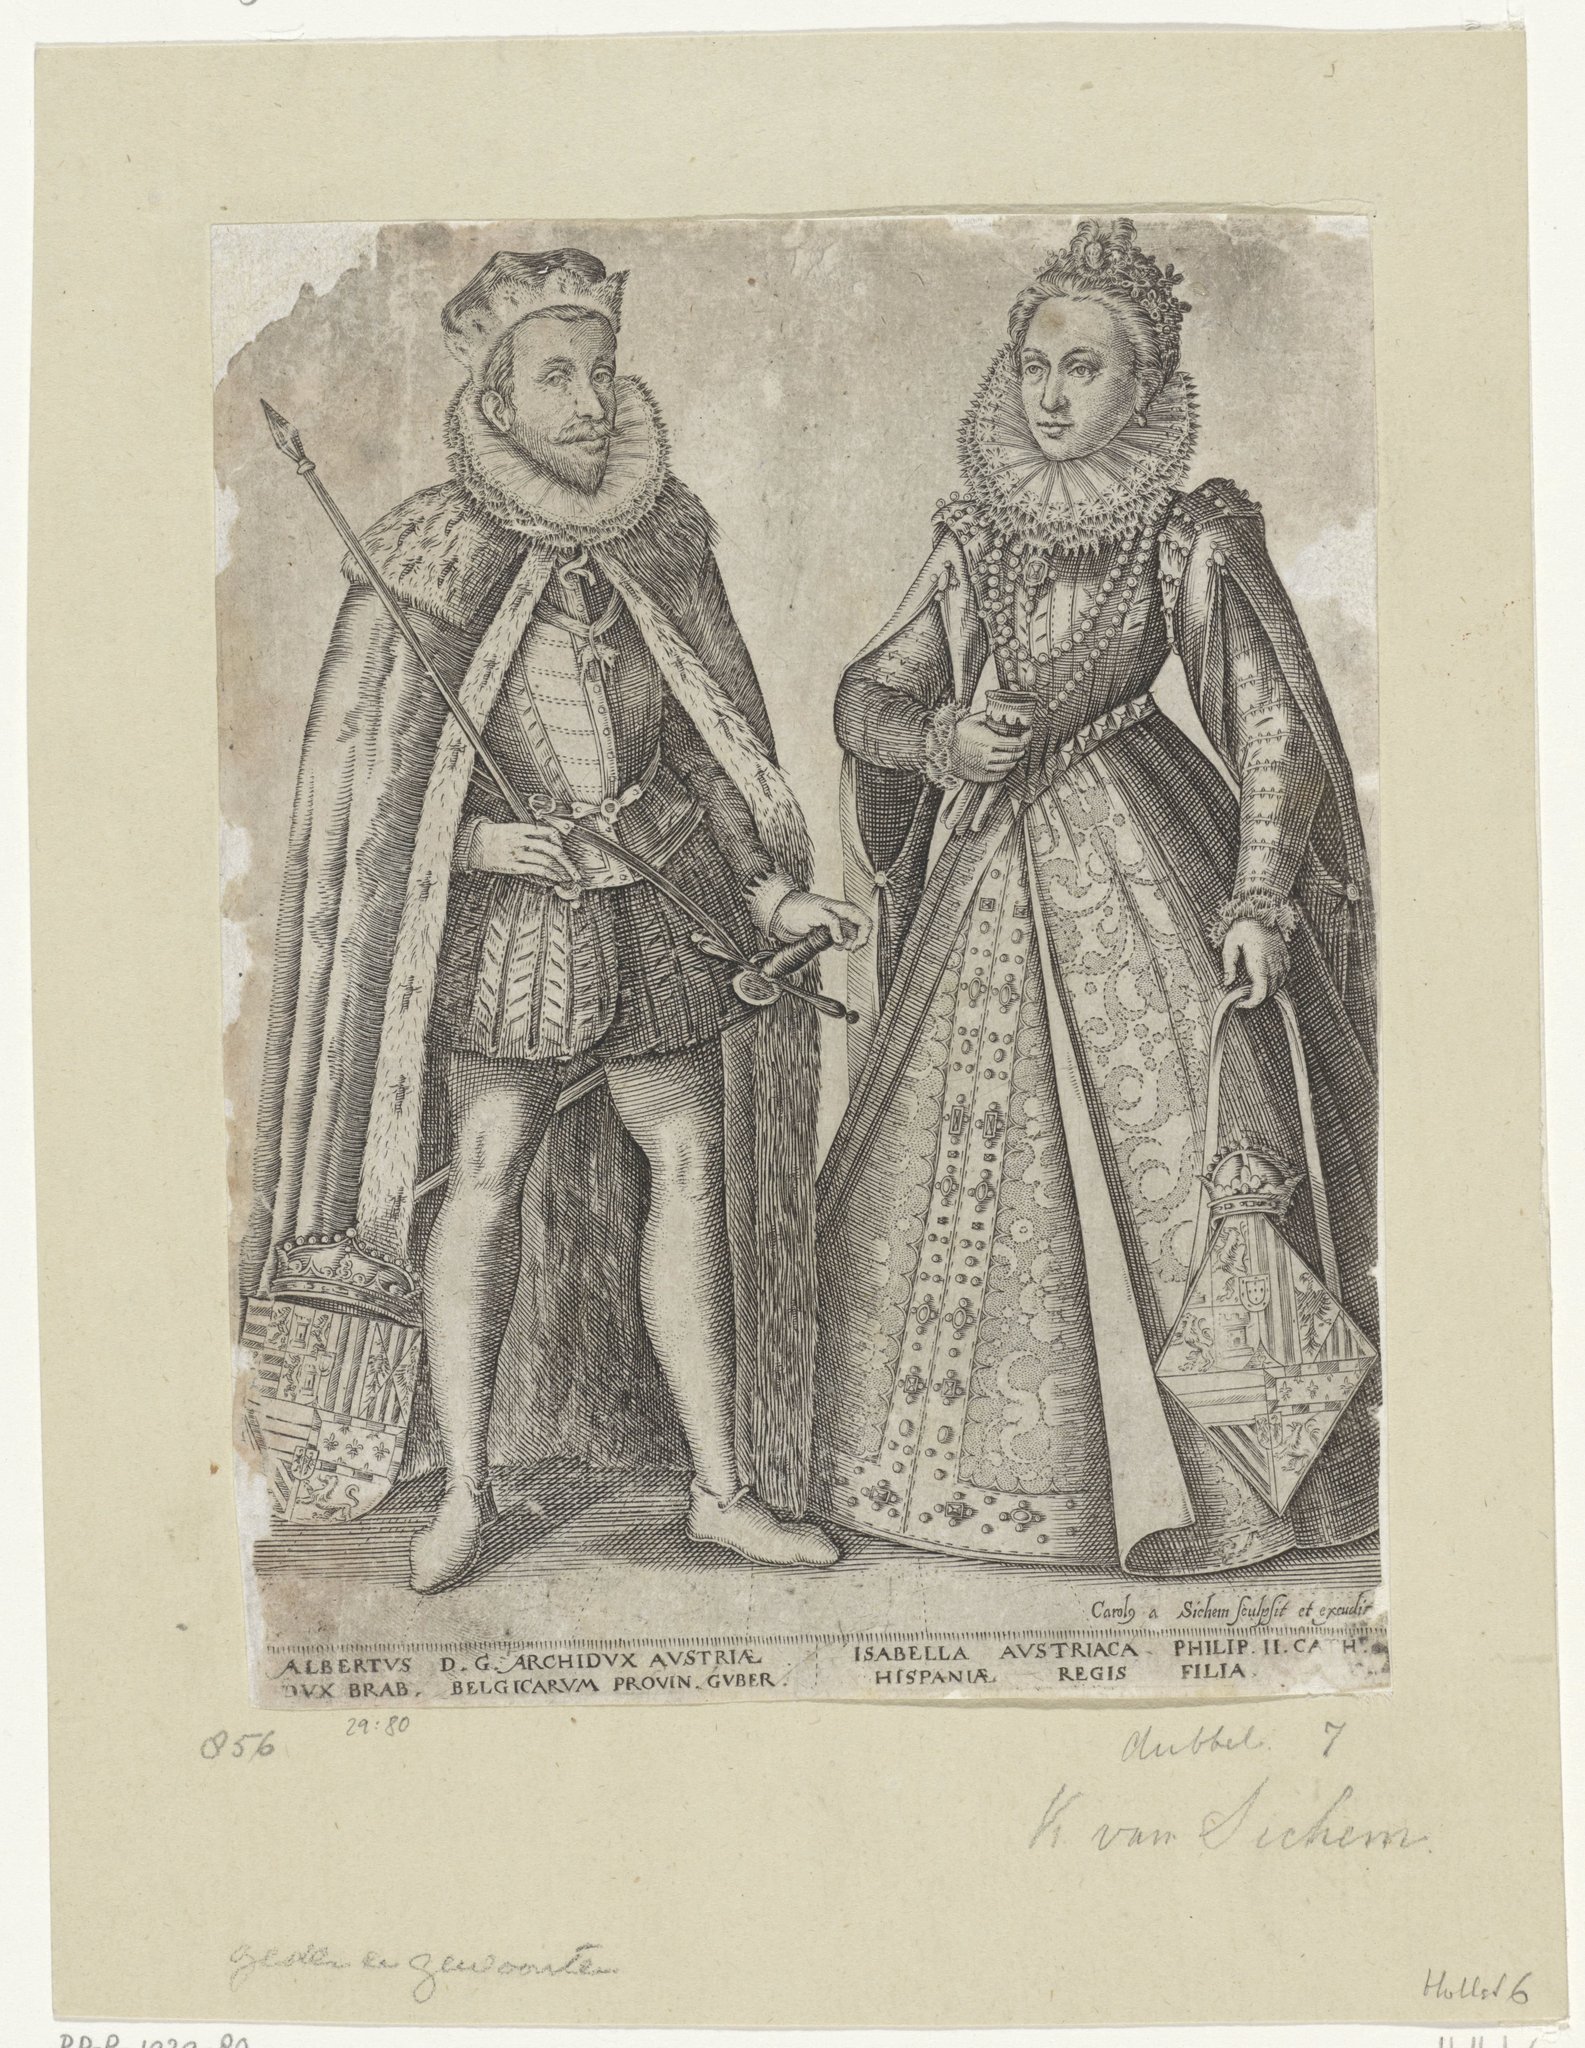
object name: print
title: Dubbelportret van Albrecht, aartshertog van Oostenrijk en Isabella van Spanje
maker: karel van sichem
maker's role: print maker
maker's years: 1575-1604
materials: paper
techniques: engraving, etching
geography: amsterdam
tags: infante van spanje isabella clara eugenia, brussels, albrecht aartshertog van oostenrijk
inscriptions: collector's mark: Lugt 2228, collector's mark: Lugt 240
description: Dubbelportret van Albrecht, aartshertog van Oostenrijk en Isabella van Spanje, landvoogden van de Zuidelijke Nederlanden. Zijn wapenschild staat op de grond naast hem, zij draagt het hare aan een lint in haar hand. Onder de portretten hun beider naam en titels.